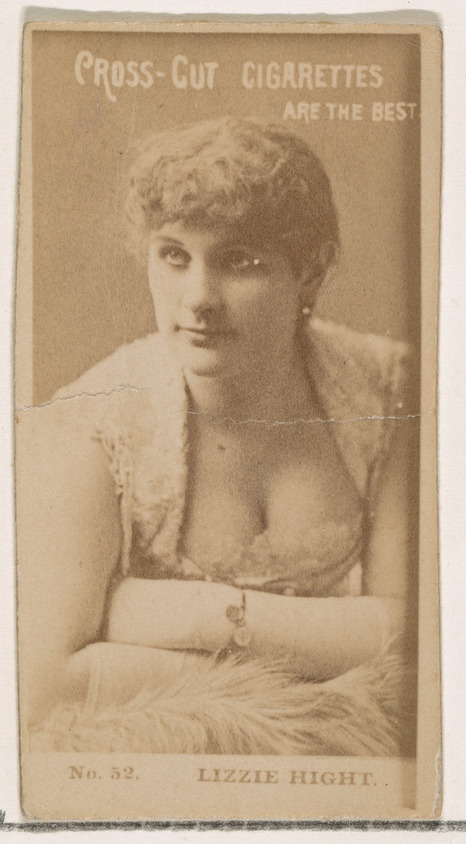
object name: print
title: Card Number 52, Lizzie Hight, from the Actors and Actresses series (N145-2) issued by Duke Sons & Co. to promote Cross Cut Cigarettes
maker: w. duke, sons & co.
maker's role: publisher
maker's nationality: american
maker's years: 1870-1920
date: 1880-1889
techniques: albumen silver print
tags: portraits,women,actresses